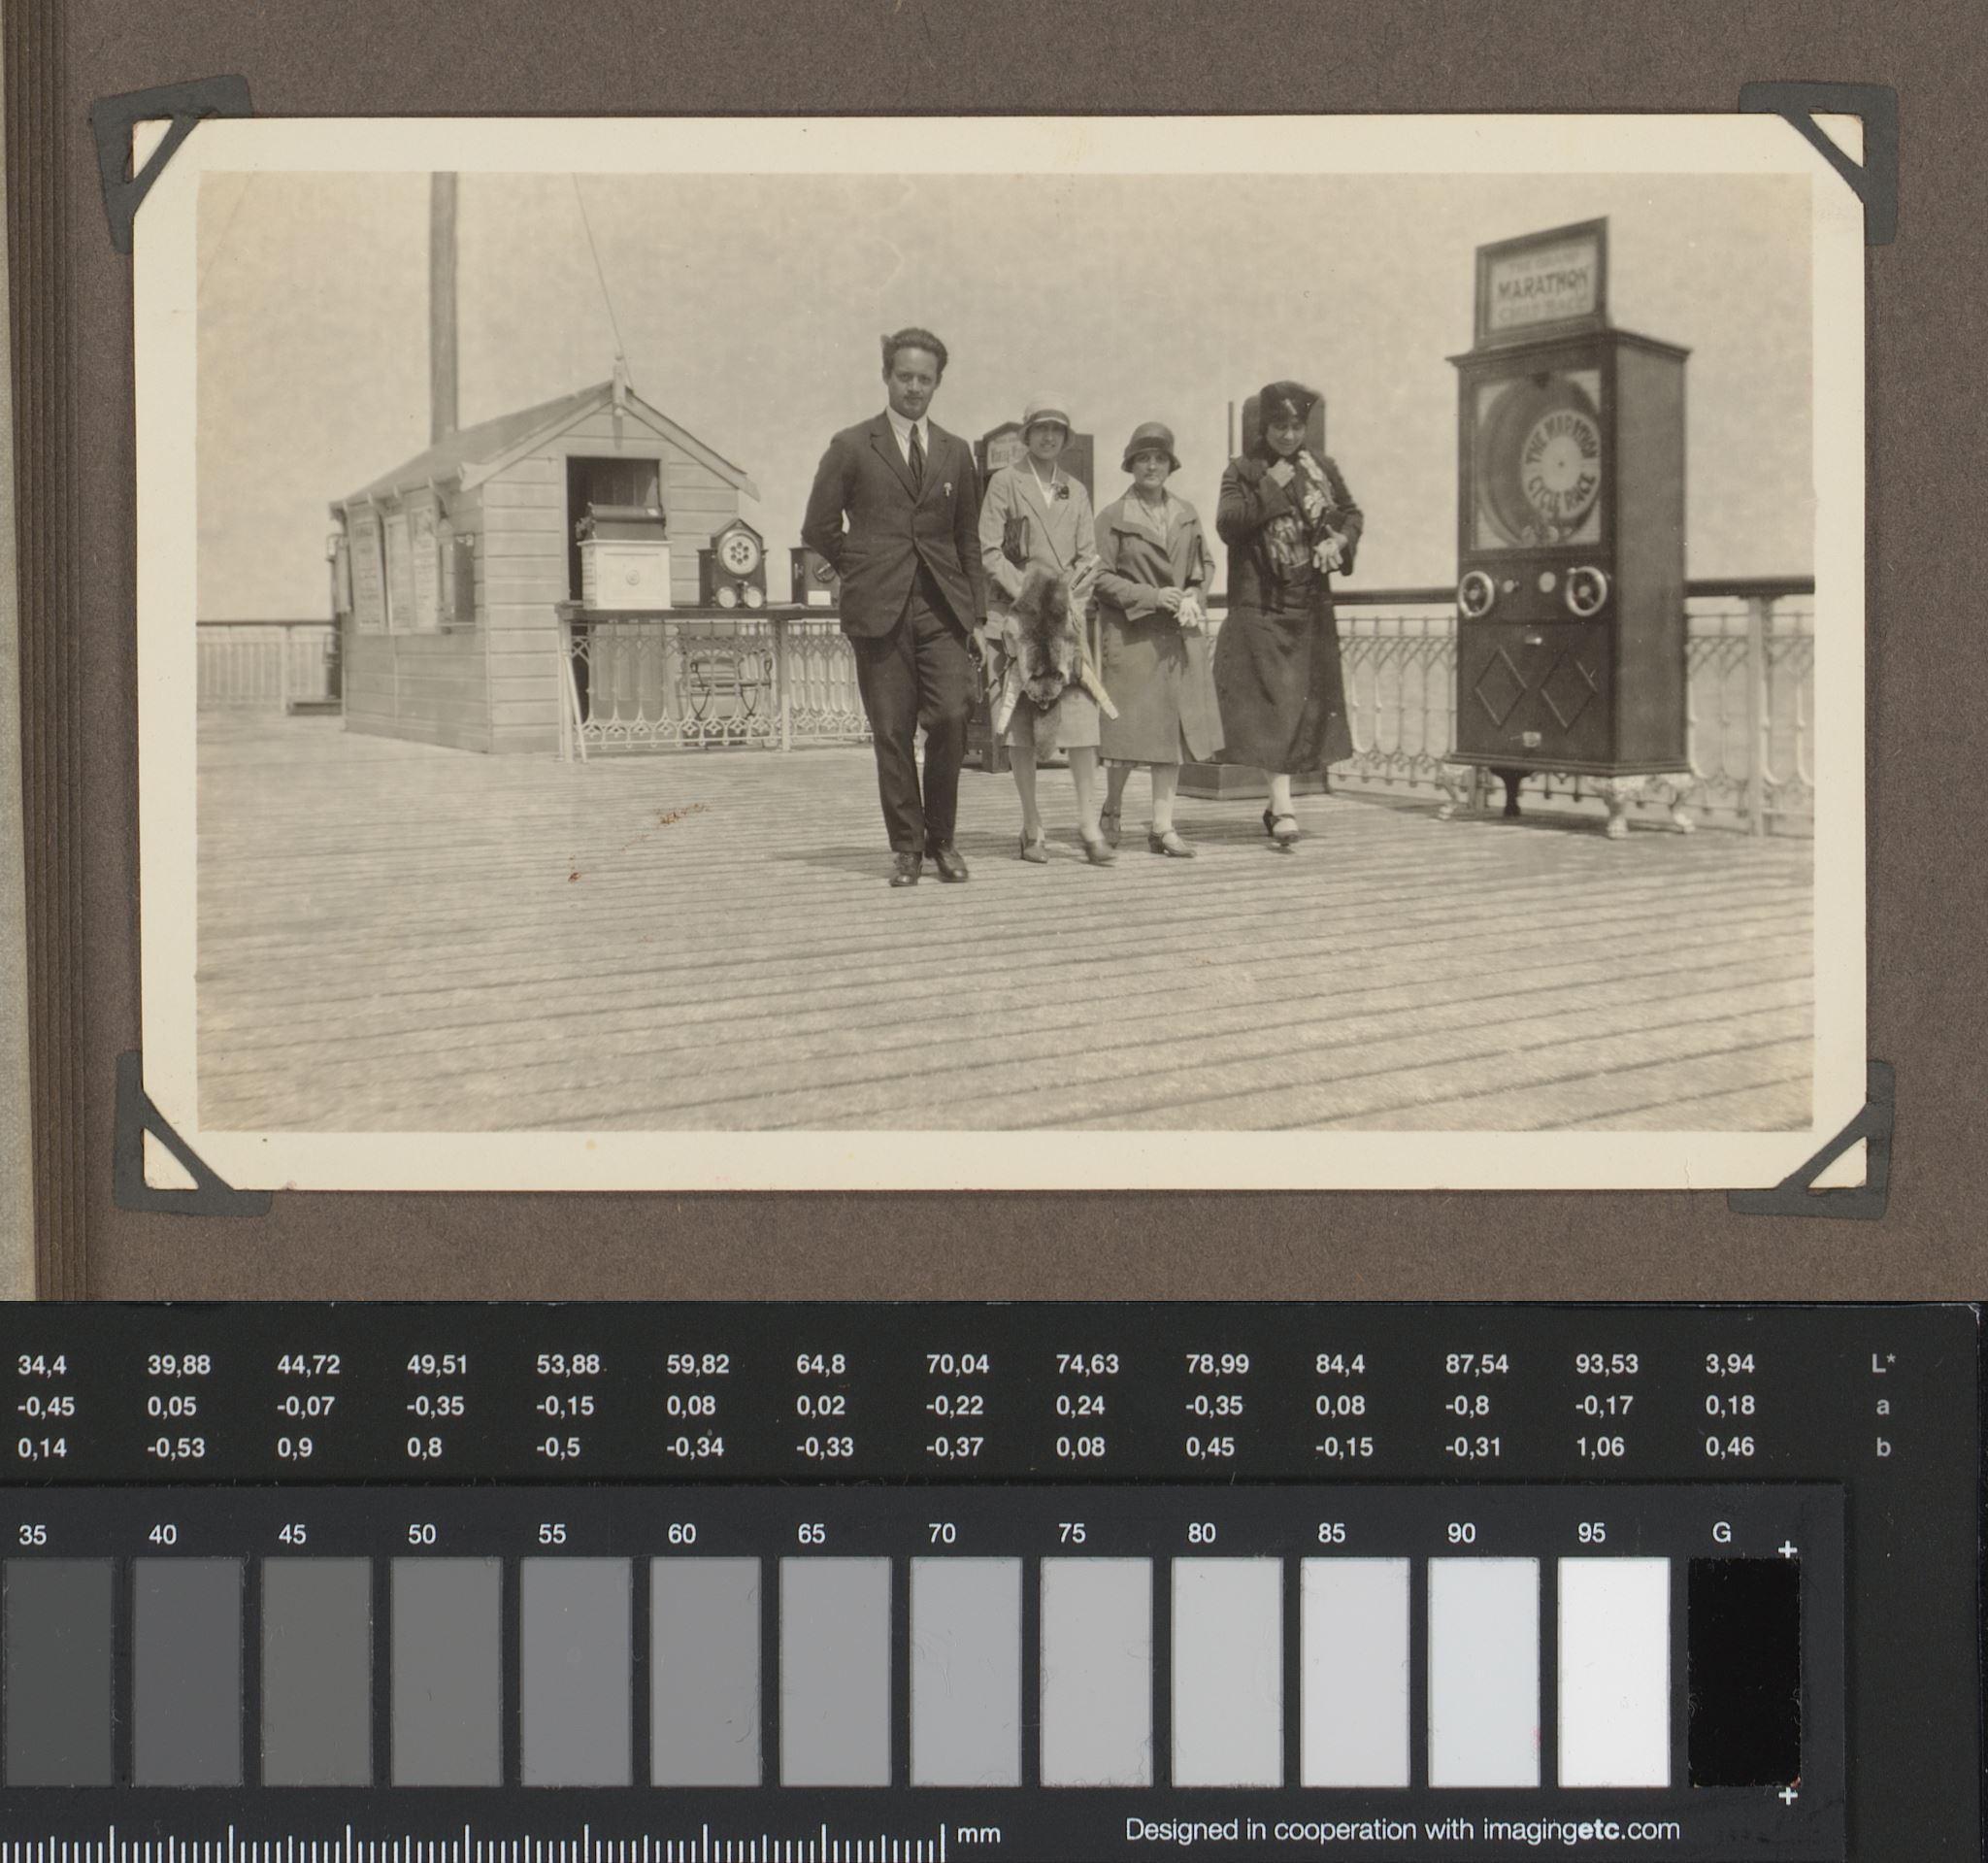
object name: album leaf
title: Johannes, Dootje, Henriëtte Wassink en Wilhelmina van Zijll de Jong, lopend over de pier van Scheveningen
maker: Anonymous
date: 1930-1935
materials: paper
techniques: gelatin silver print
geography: scheveningen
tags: henriëtte wassink, amsterdam, the hague, wilhelmina van zijll de jong, adult woman, adult man